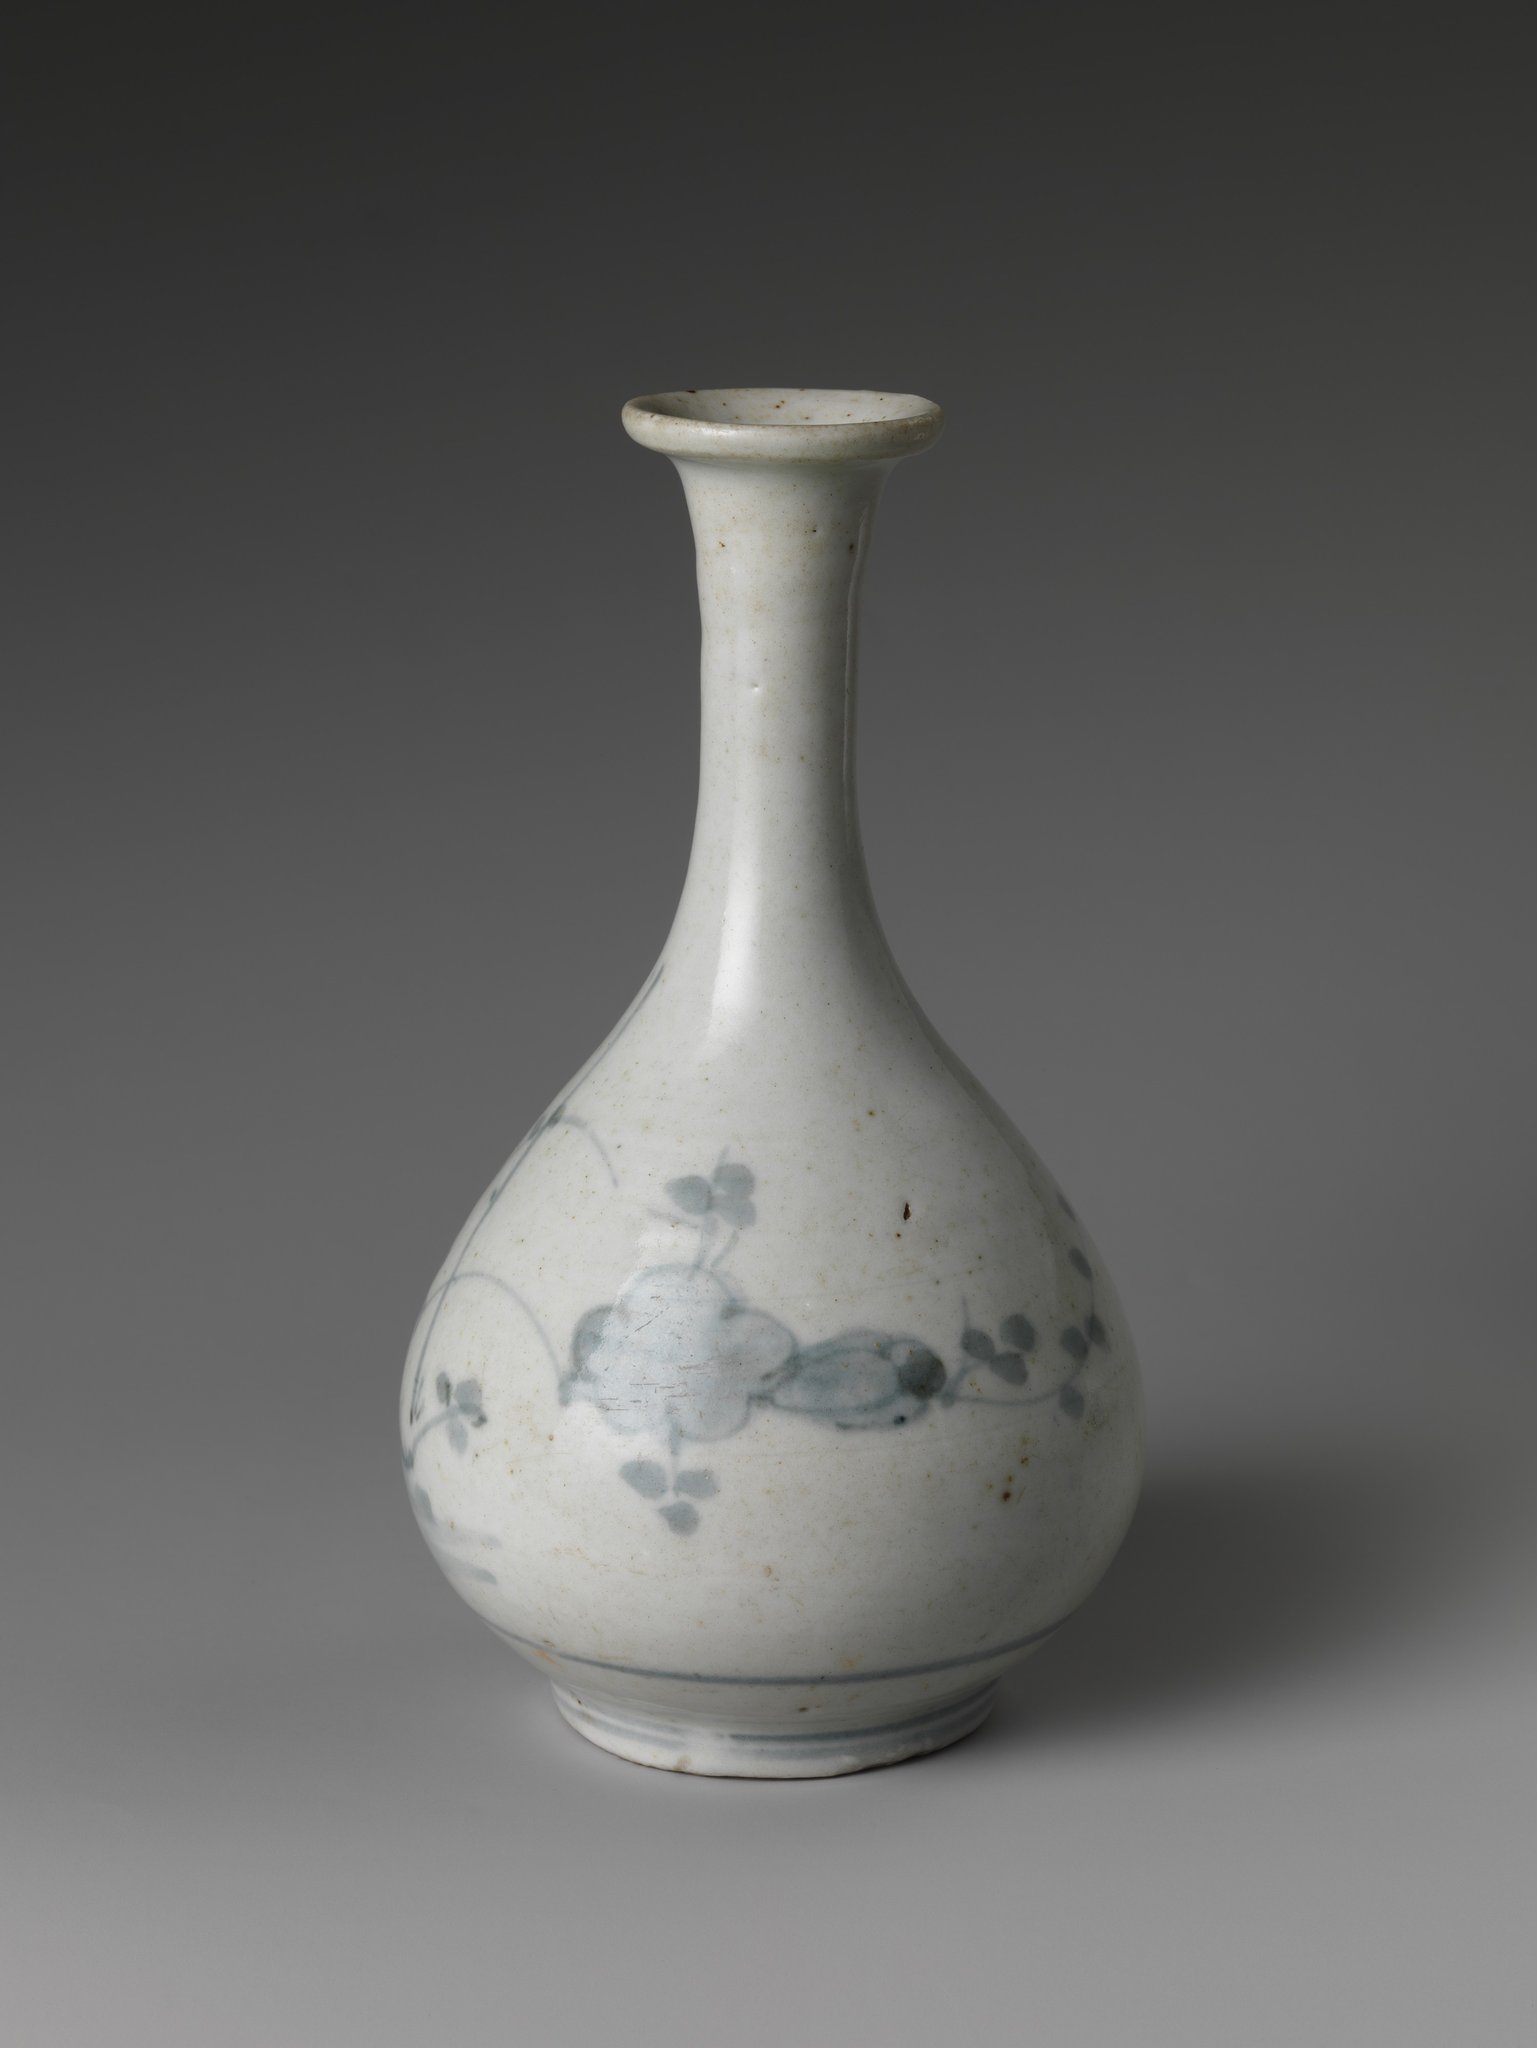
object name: wine bottle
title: Wine Bottle with Flowers and Grasses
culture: japanese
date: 1601-1650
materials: porcelain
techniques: underglaze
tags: plants